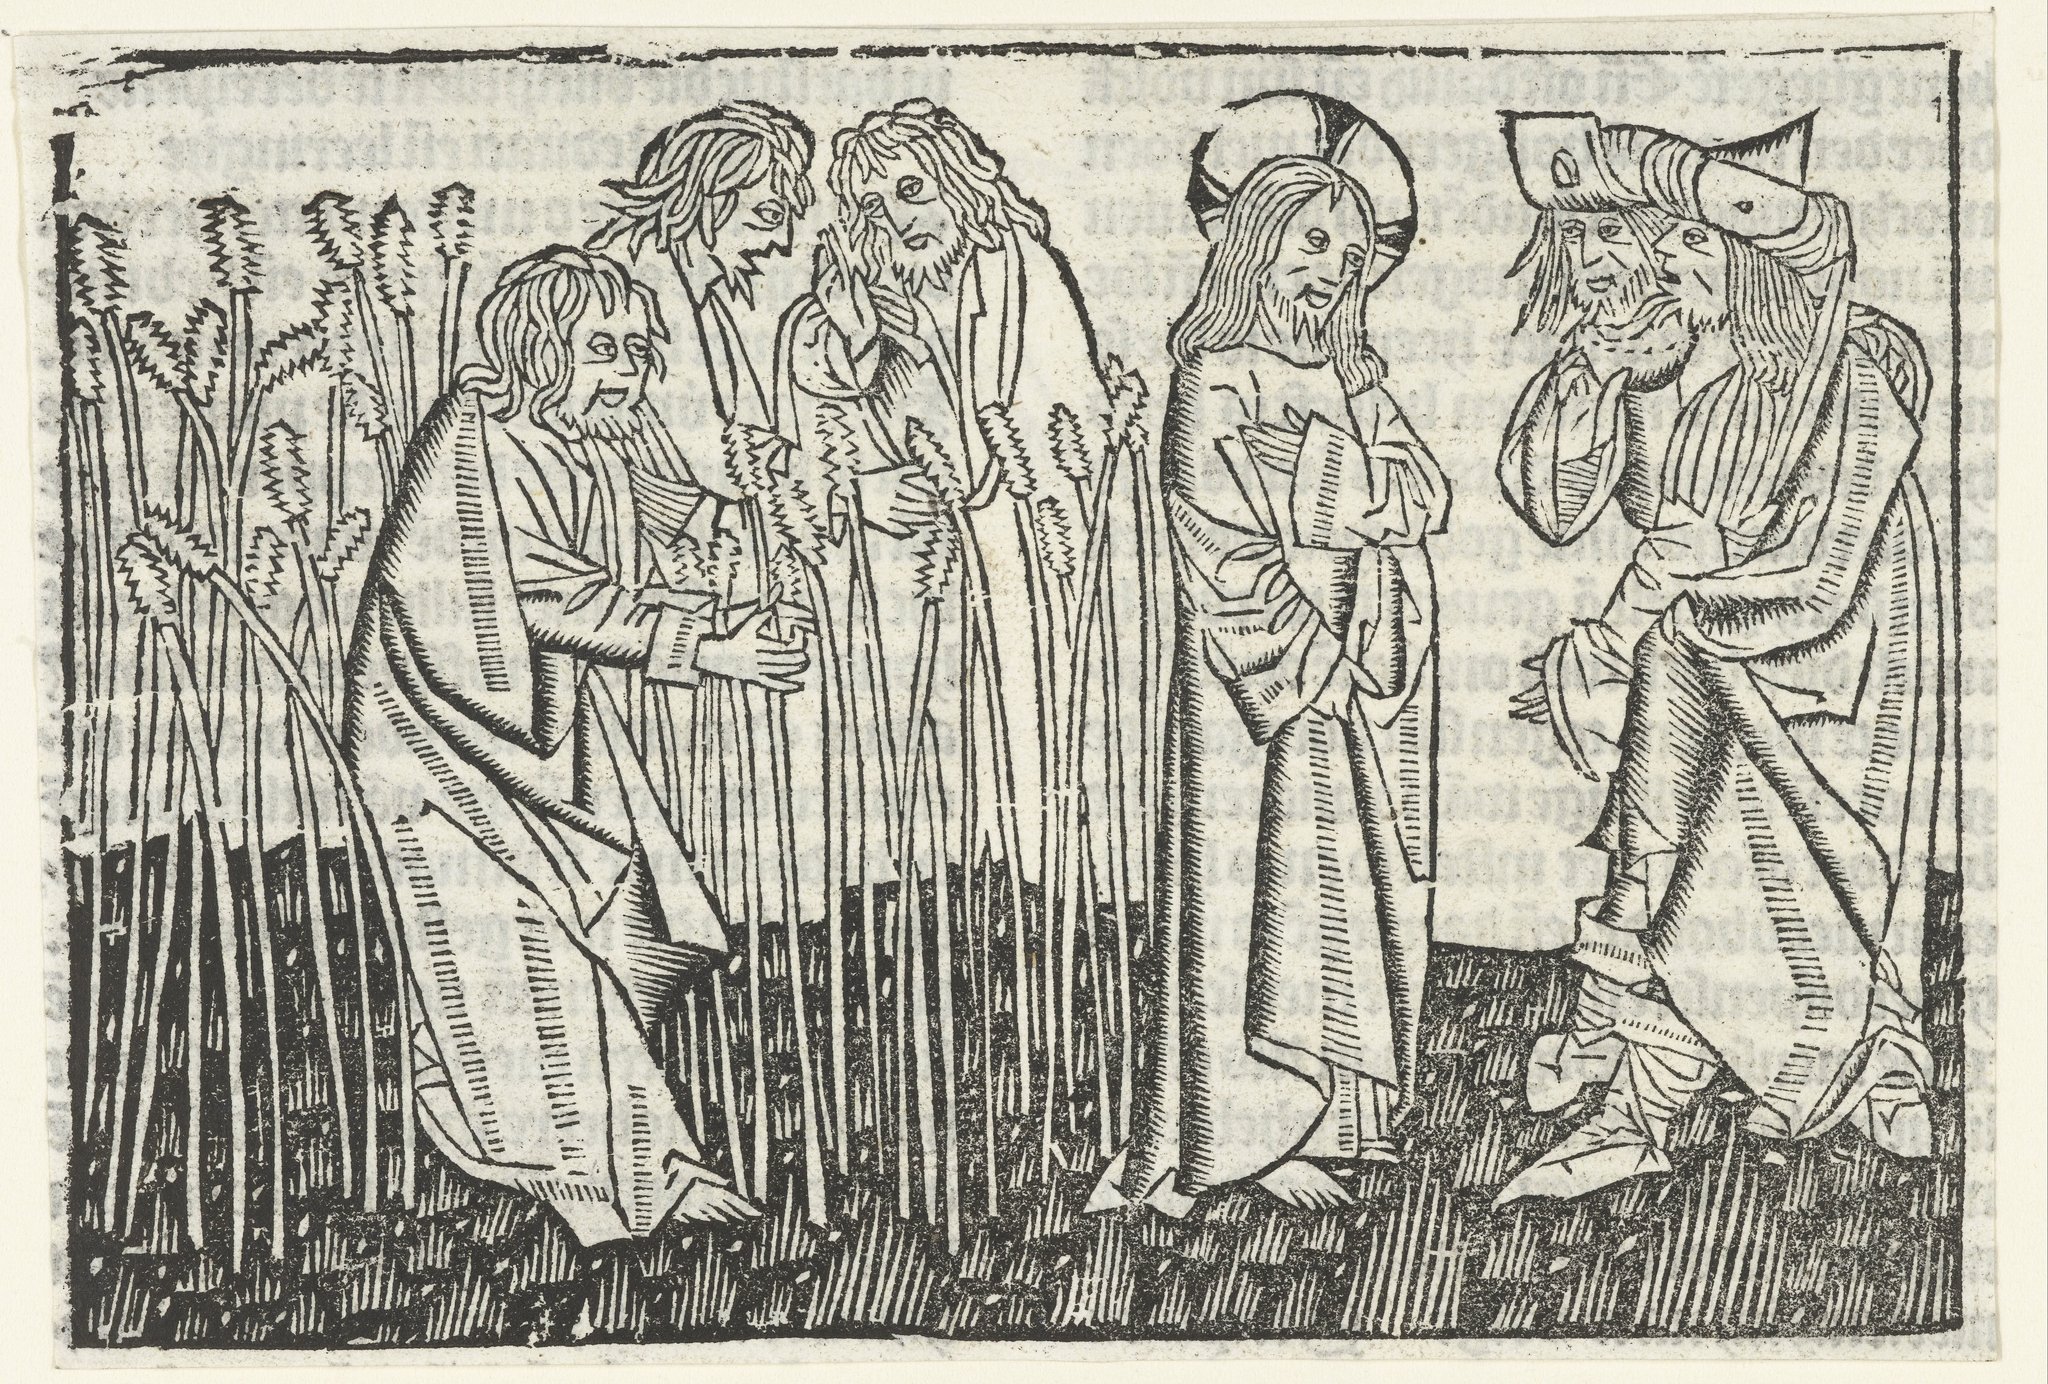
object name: book illustration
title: De discipelen plukken en eten aren op de sabbat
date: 1480-1500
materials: paper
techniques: woodcut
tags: disciples pluck ears of corn on sabbath, and eat (matthew 12:1-8; mark 2:23-28; luke 6:1-5)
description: Eén blad van 113 uit Ludolphus de Saxonia, "Dit es dleué ons liefs heeren ihesu christi". Anonieme Nederlandse vertaling. Uitgegeven door Henrick Eckert van Homberch te Antwerpen in 1503. Botke, K. Deze 113 houtsneden, die meestal reeds in vroege Nederlandse boeken gebruikt zijn, worden toegeschreven aan de tweede Meester van Delft, de Meester van de Delbecq-Schreiber-passie en de Meester van de Virgo inter Virgines. In Conway (1884) en in "De gulden passer"(1951) zijn ook eerdere versies opgenomen. Botke, K.